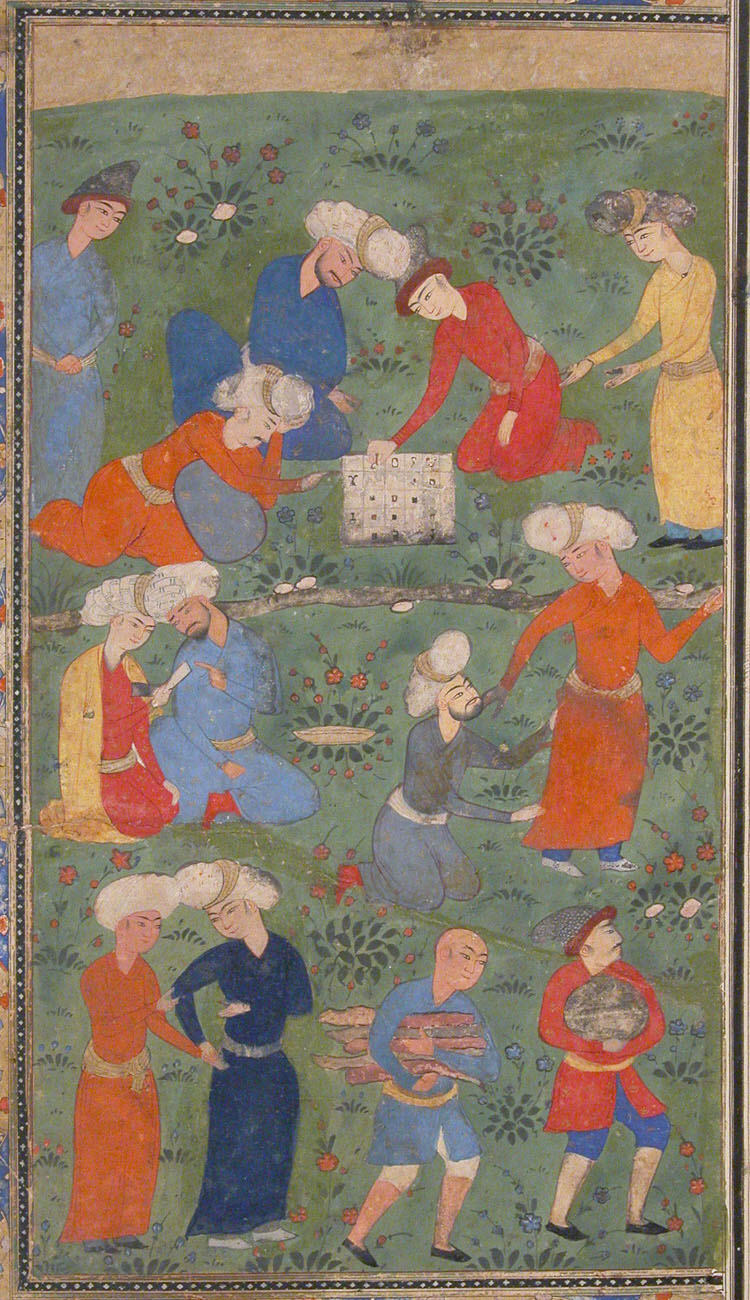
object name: folio from an illustrated manuscript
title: "Preparing a Noonday Meal on an Outing", Folio from a Kulliyat (Complete Works) of Sa'di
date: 1801-1900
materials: gold, ink, paper, watercolor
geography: india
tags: men,women